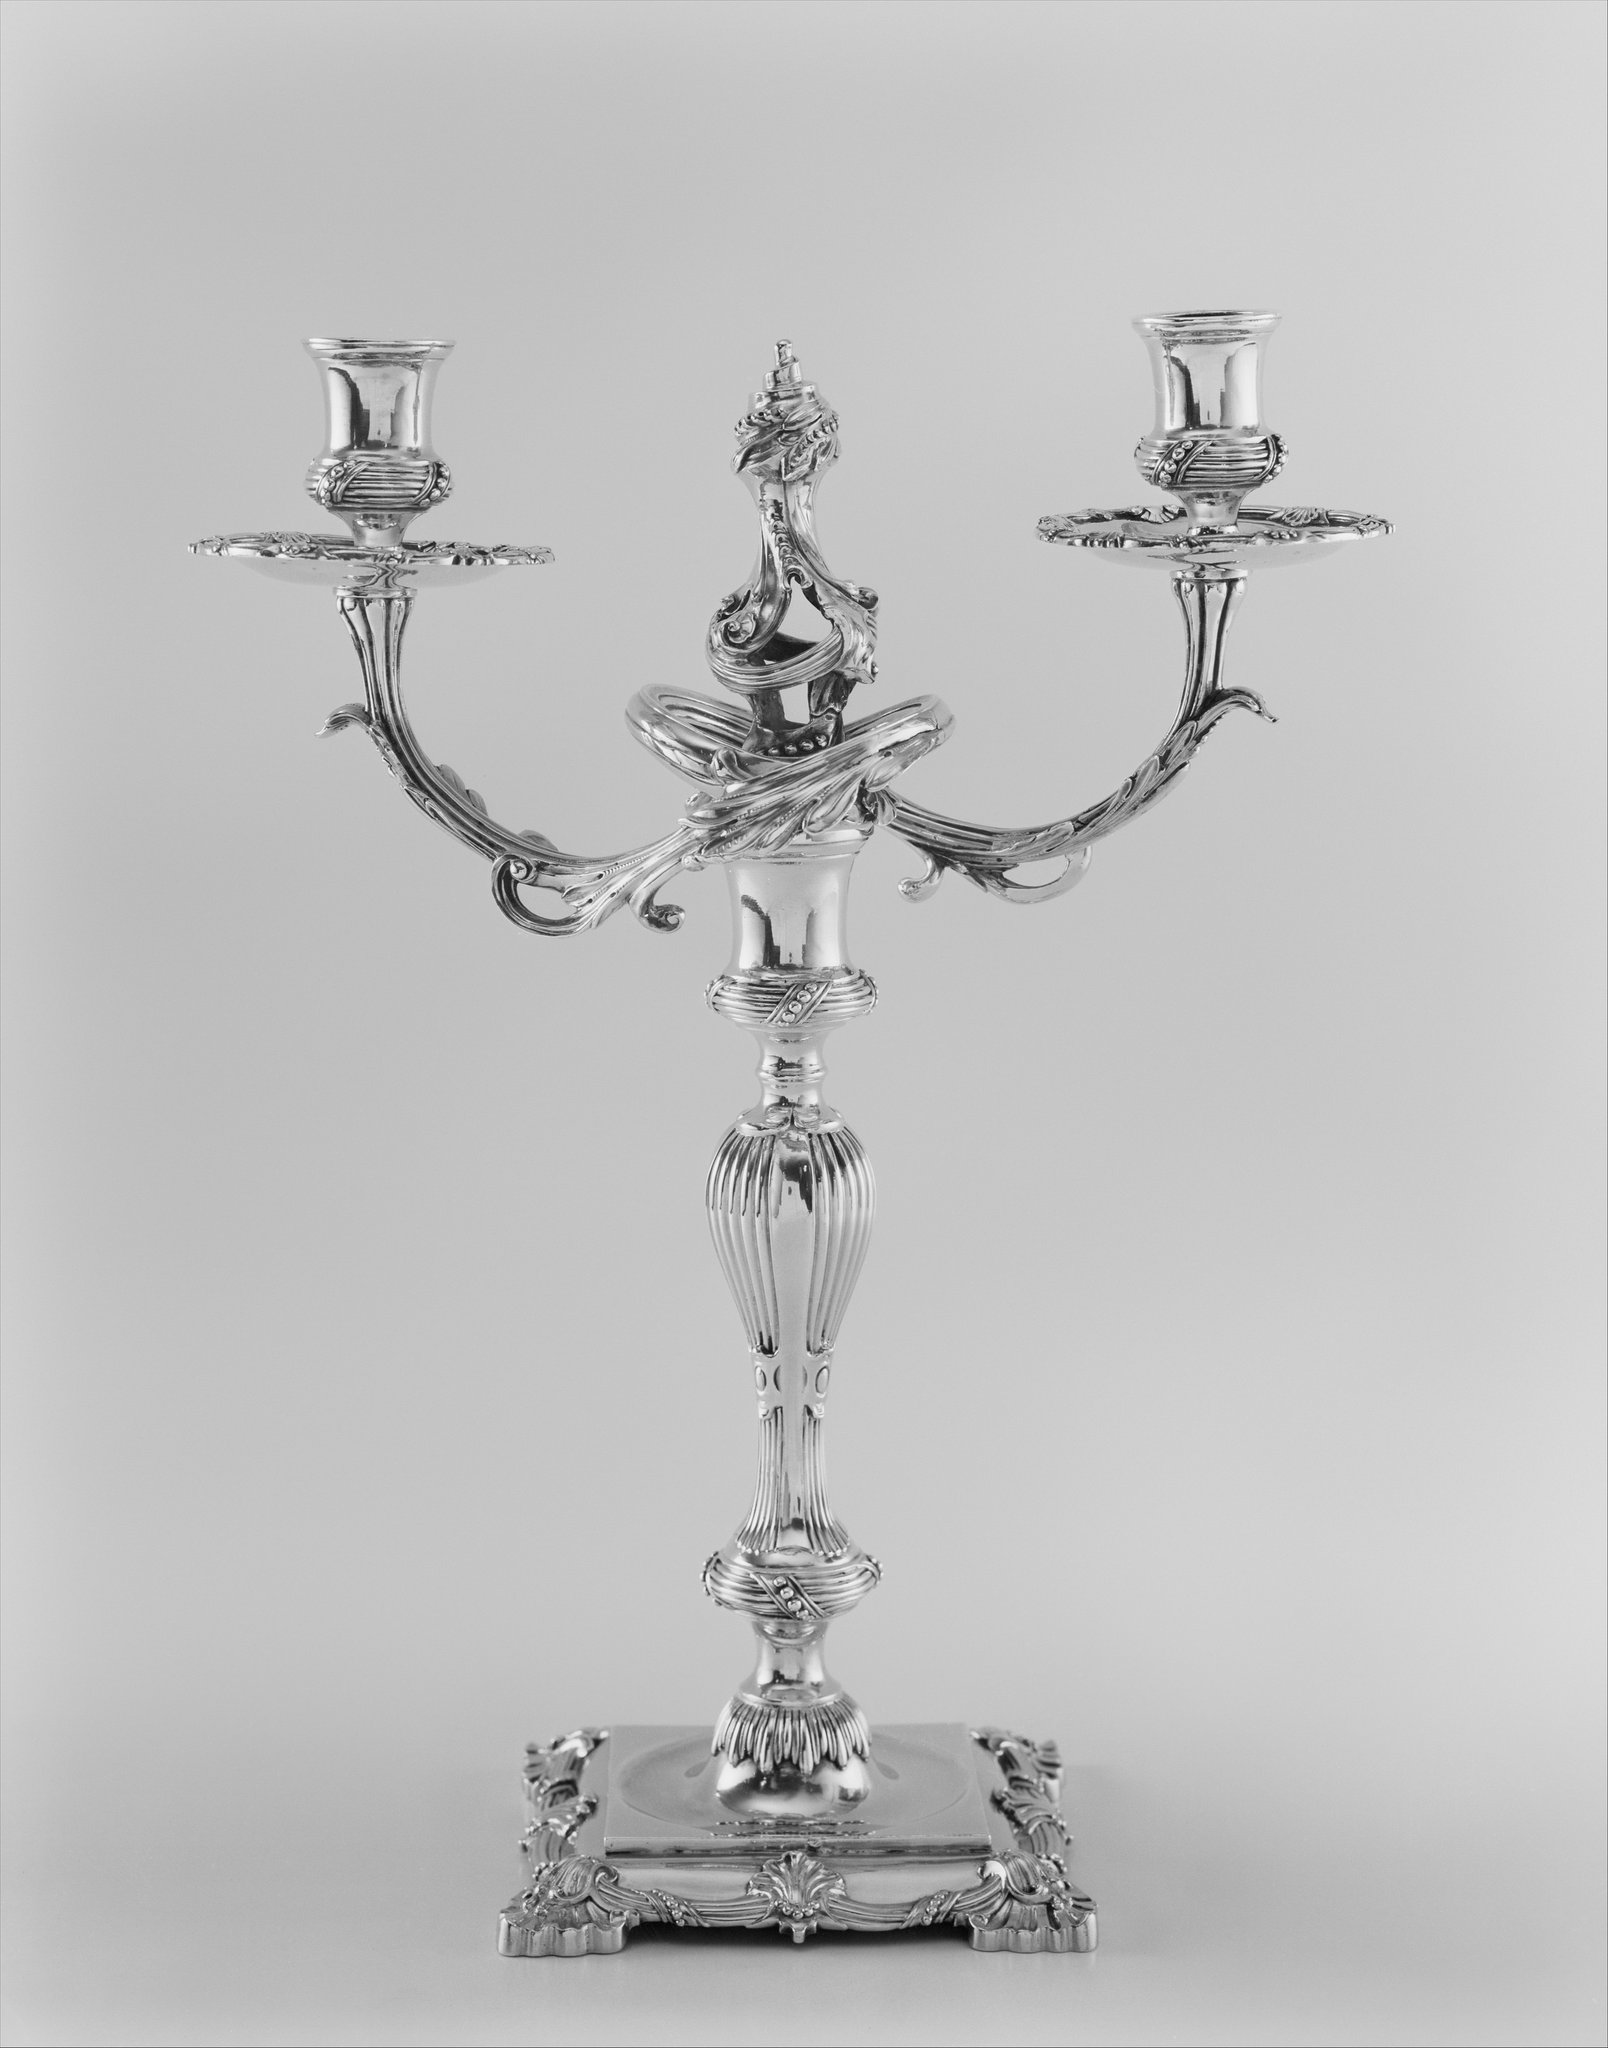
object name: candelabrum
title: Pair of candelabra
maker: john carter ii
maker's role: maker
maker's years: 1768-1777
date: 1771-1772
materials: silver gilt